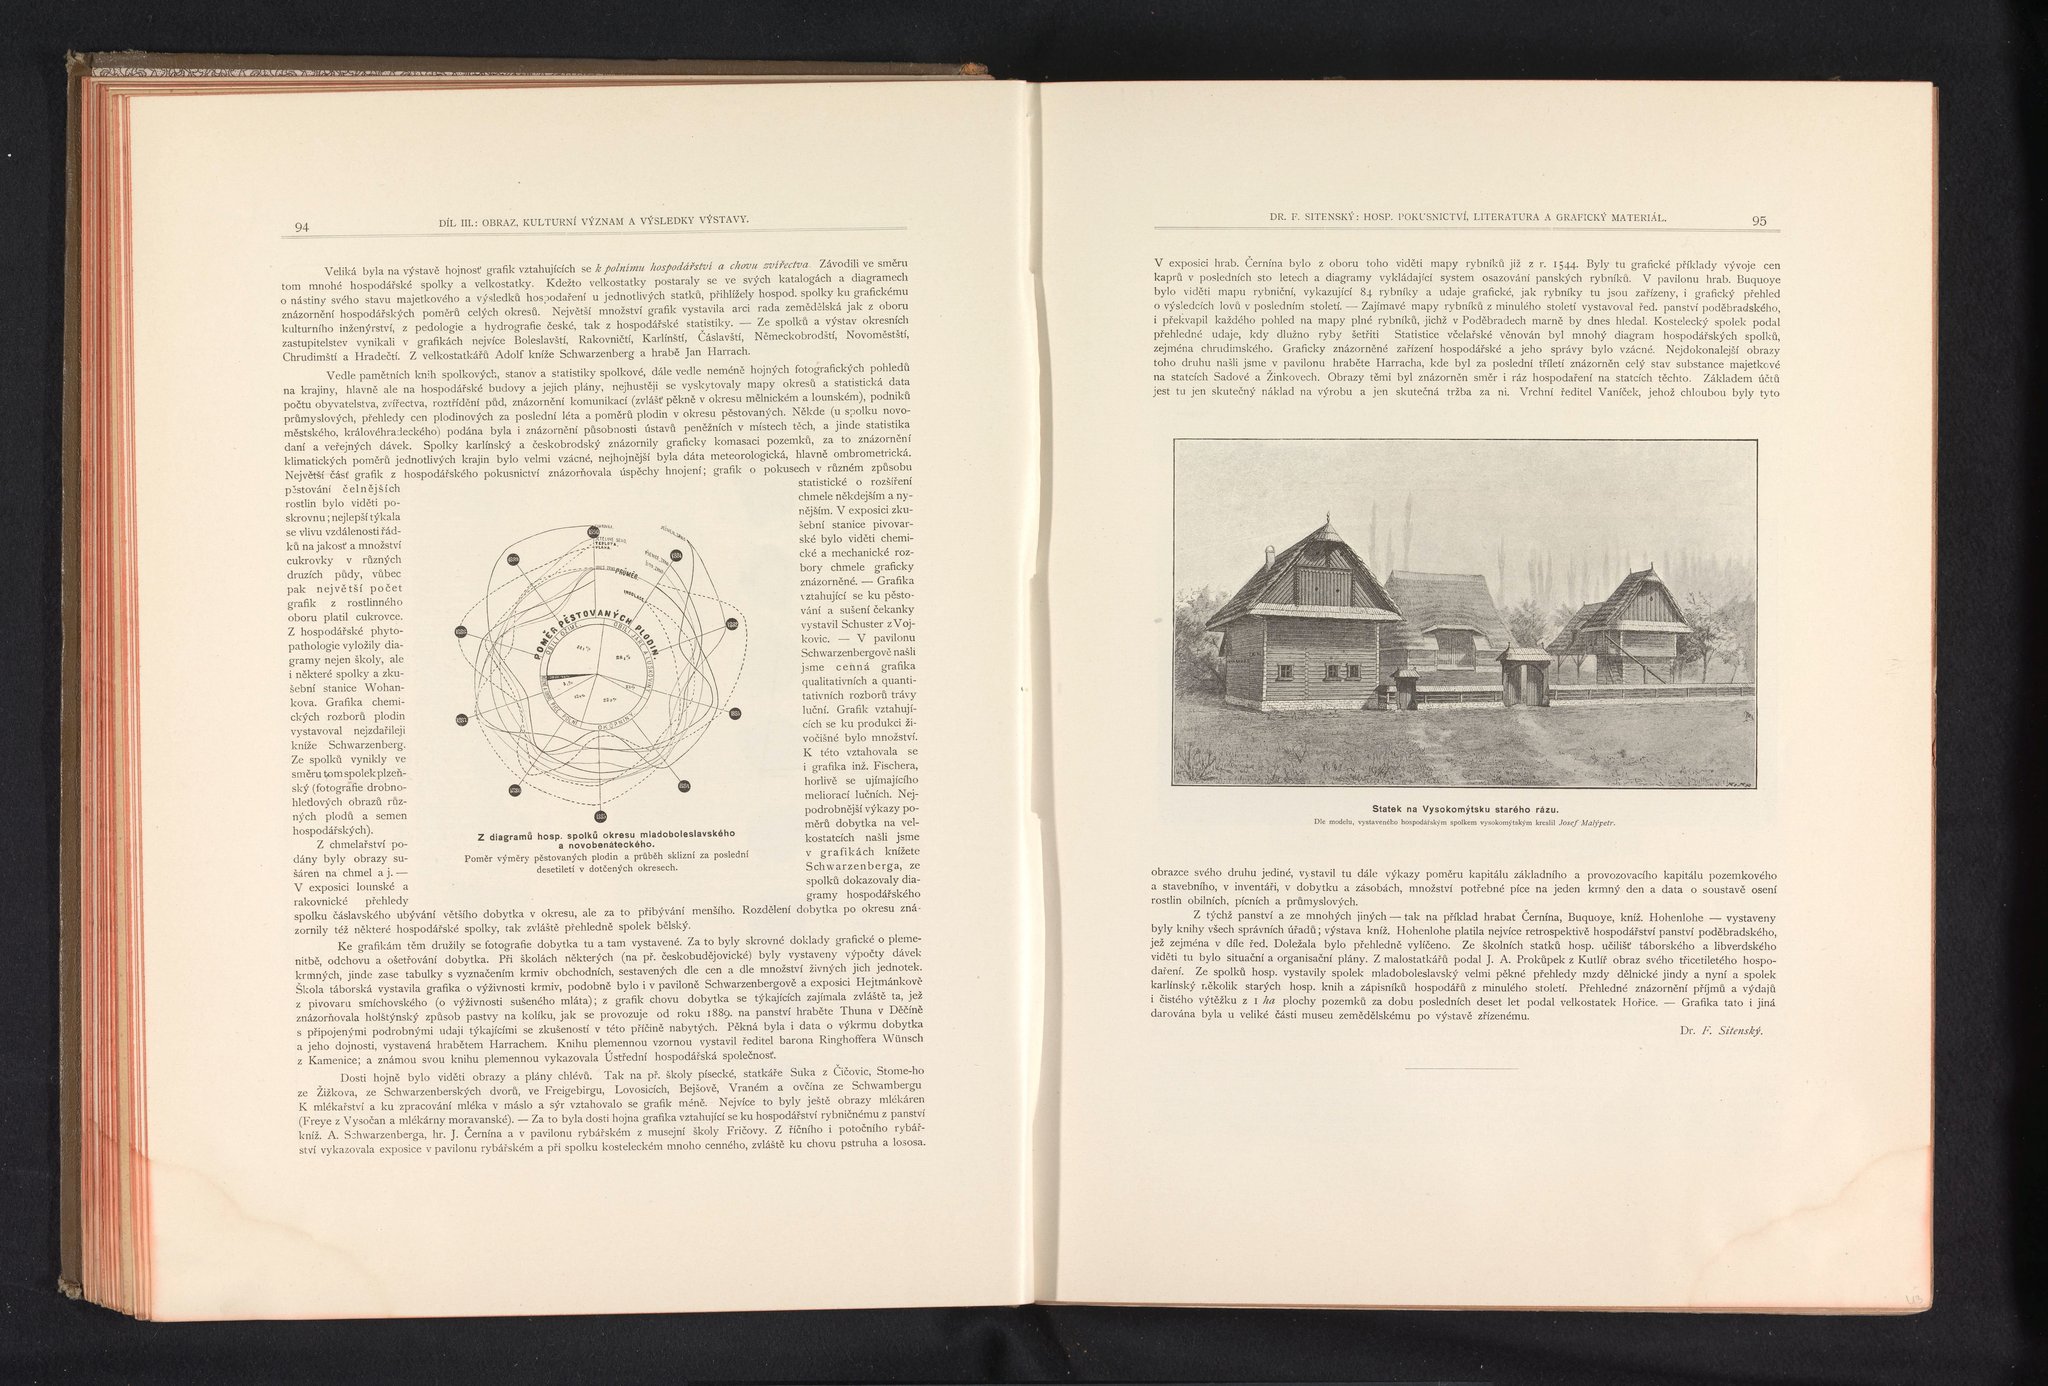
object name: reproduction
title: Statek na Vysokomýtsku starého rázu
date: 1891-1895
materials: paper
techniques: autotype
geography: prague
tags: façade (of house or building), farm (building)